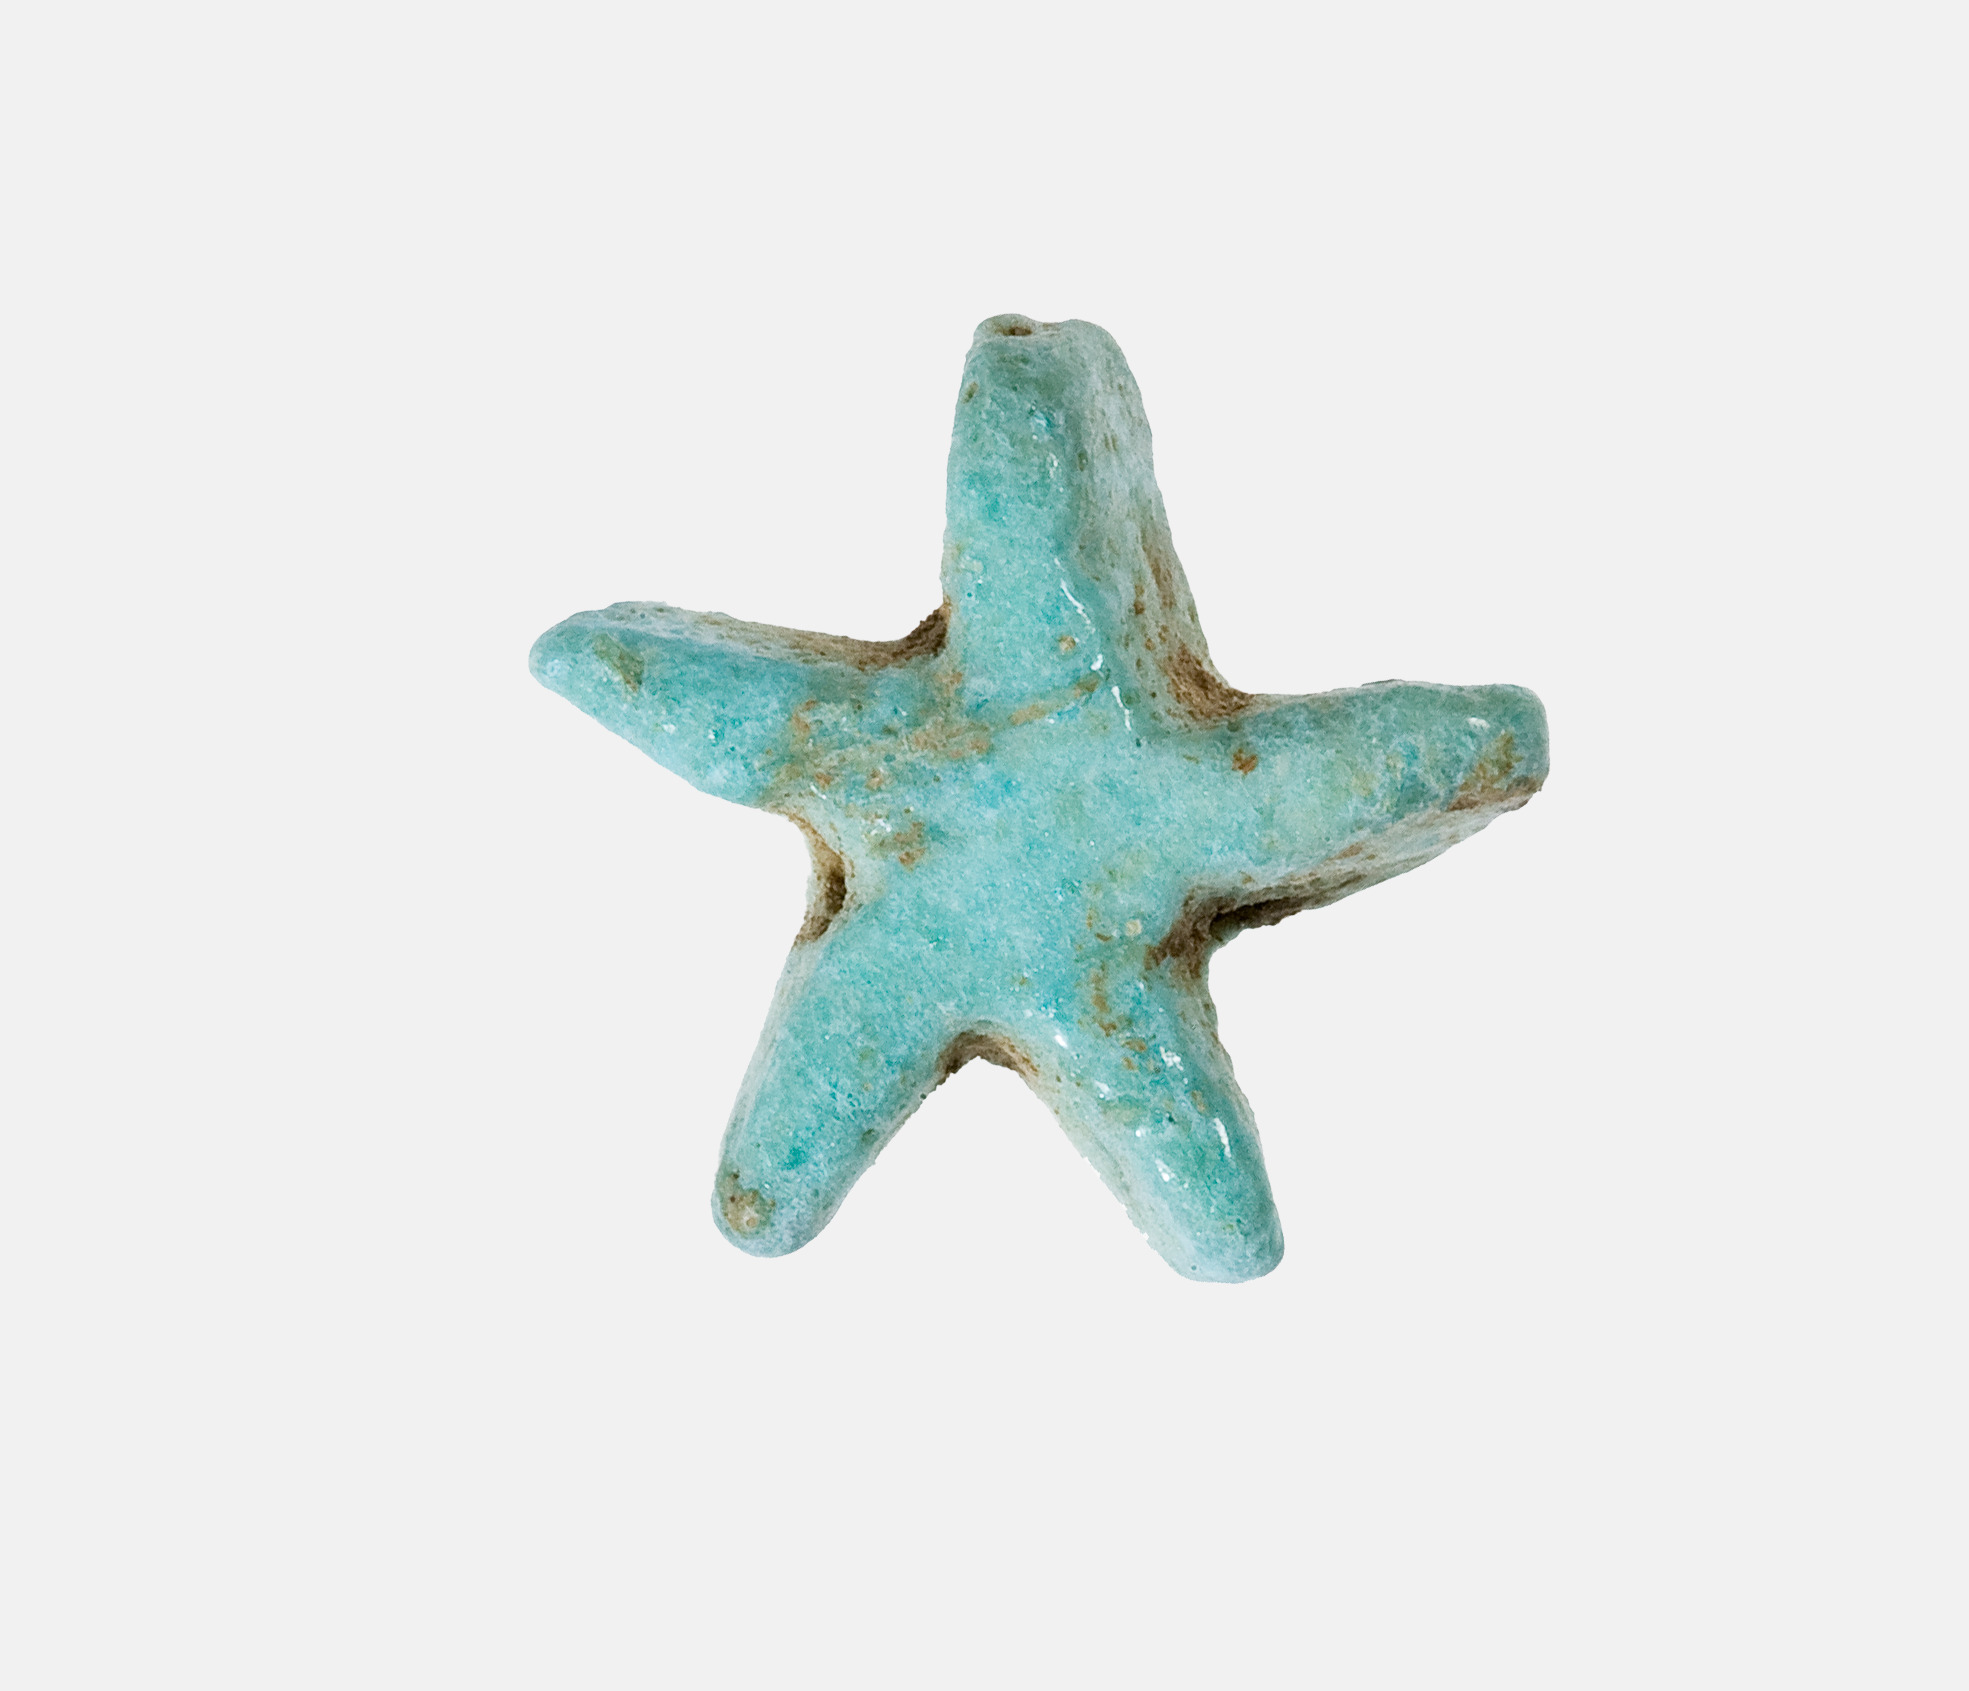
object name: amulet, star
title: Star Amulet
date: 1802-1450 BCE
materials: faience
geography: egypt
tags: stars